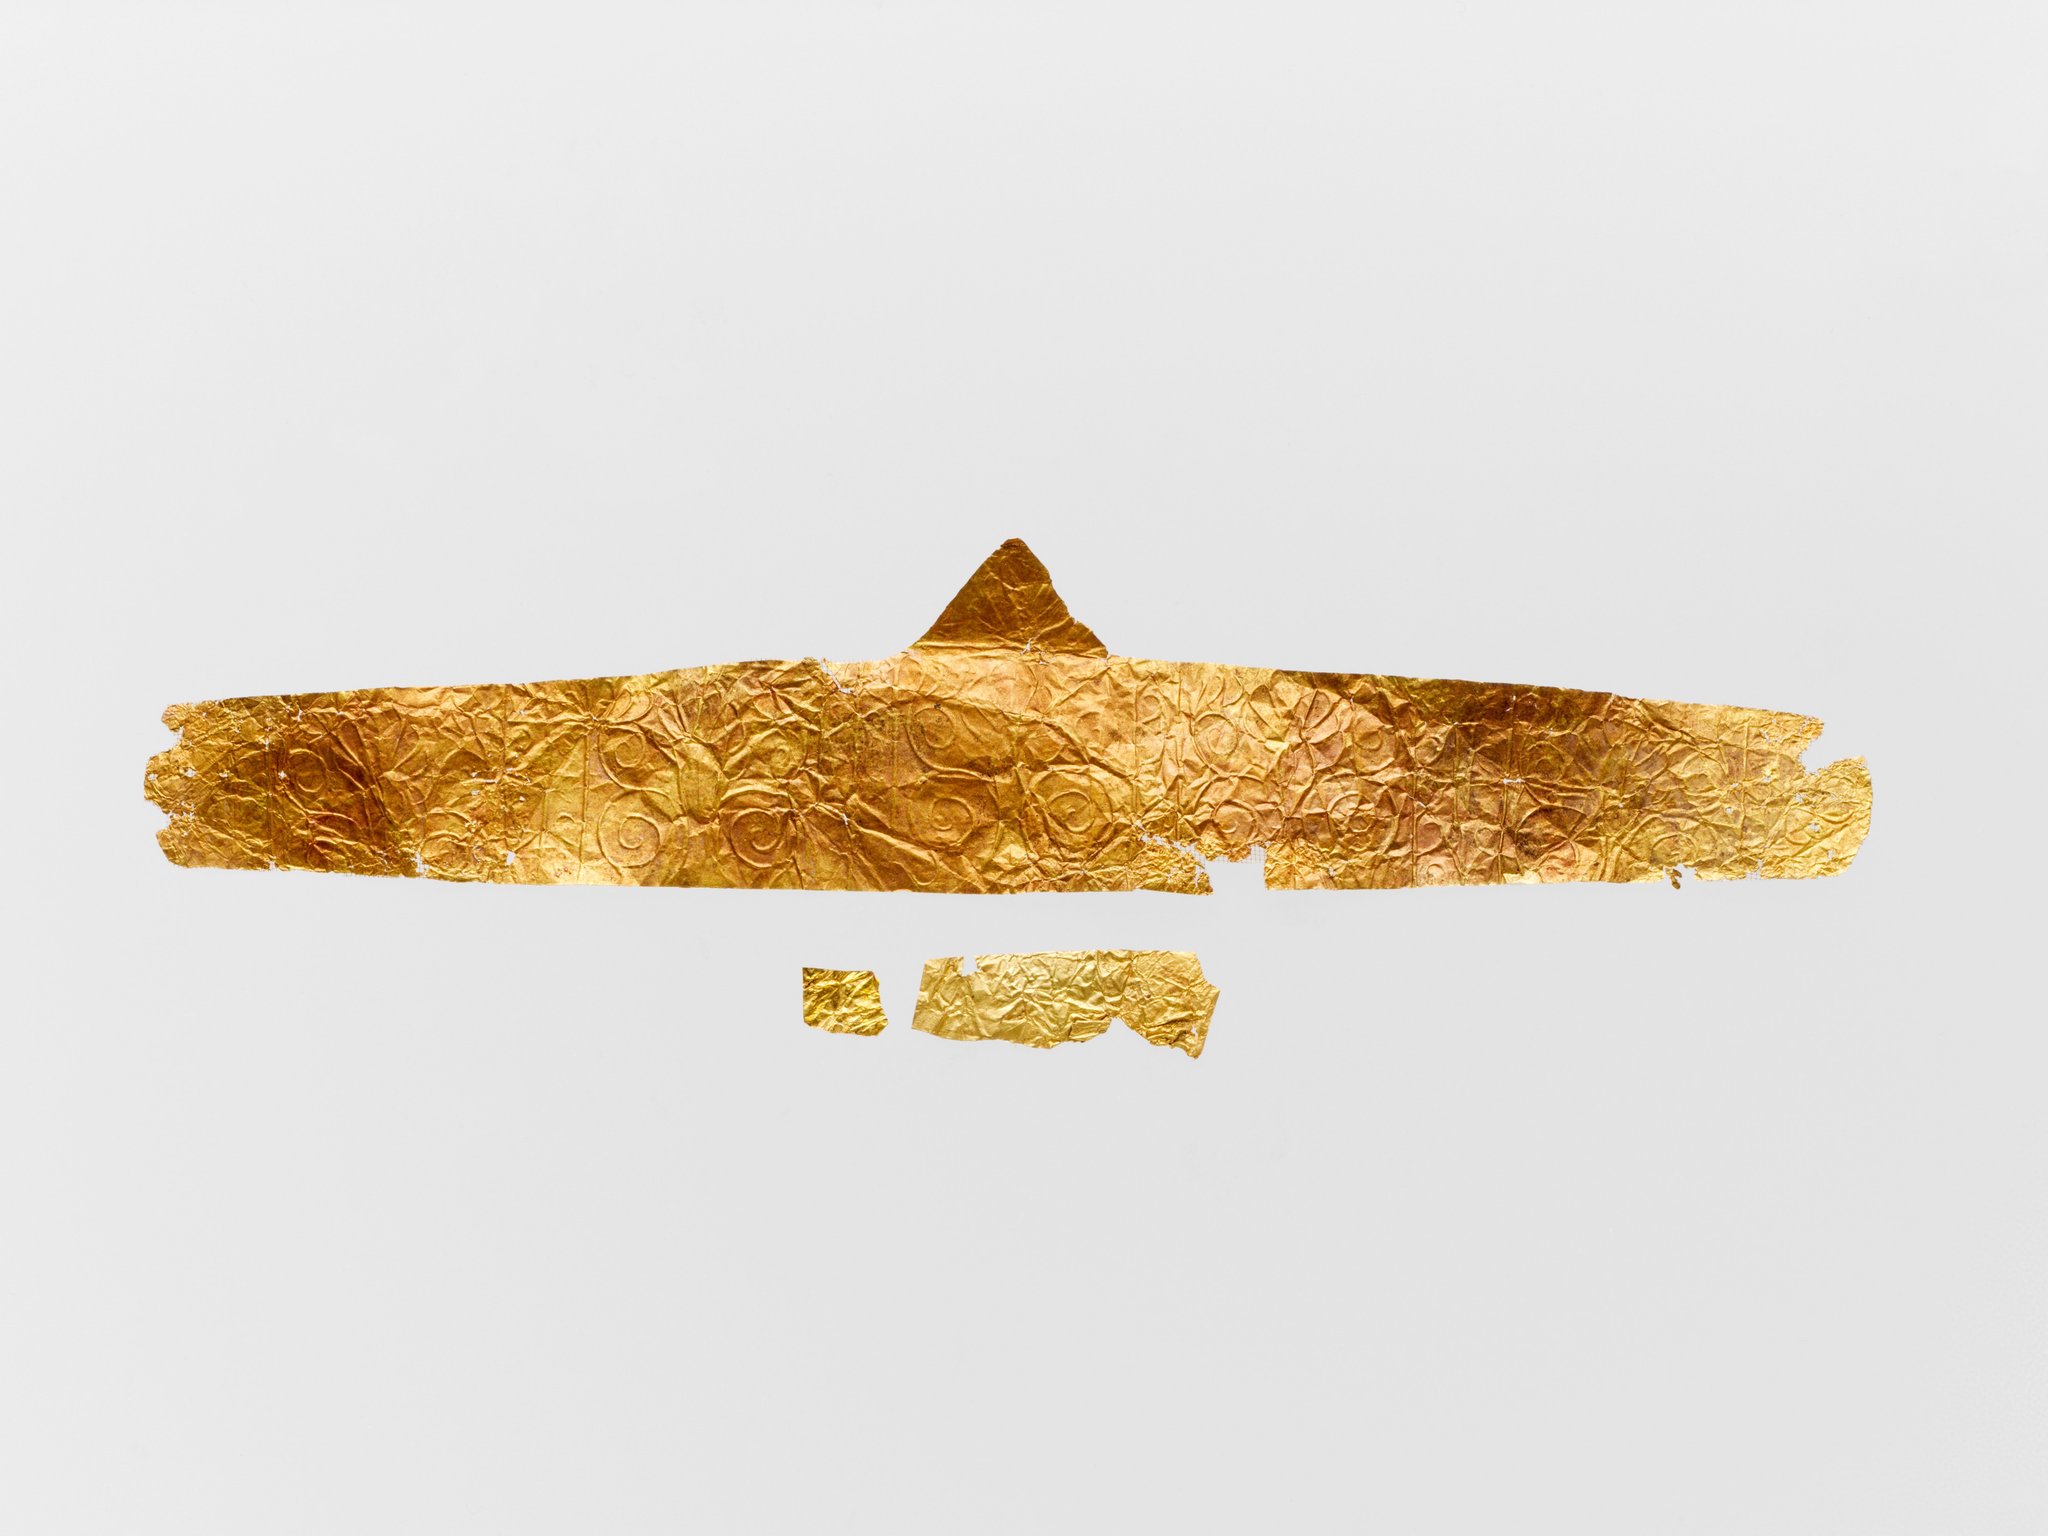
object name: diadem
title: Gold diadem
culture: cypriot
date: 400-301 BCE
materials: gold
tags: diadems